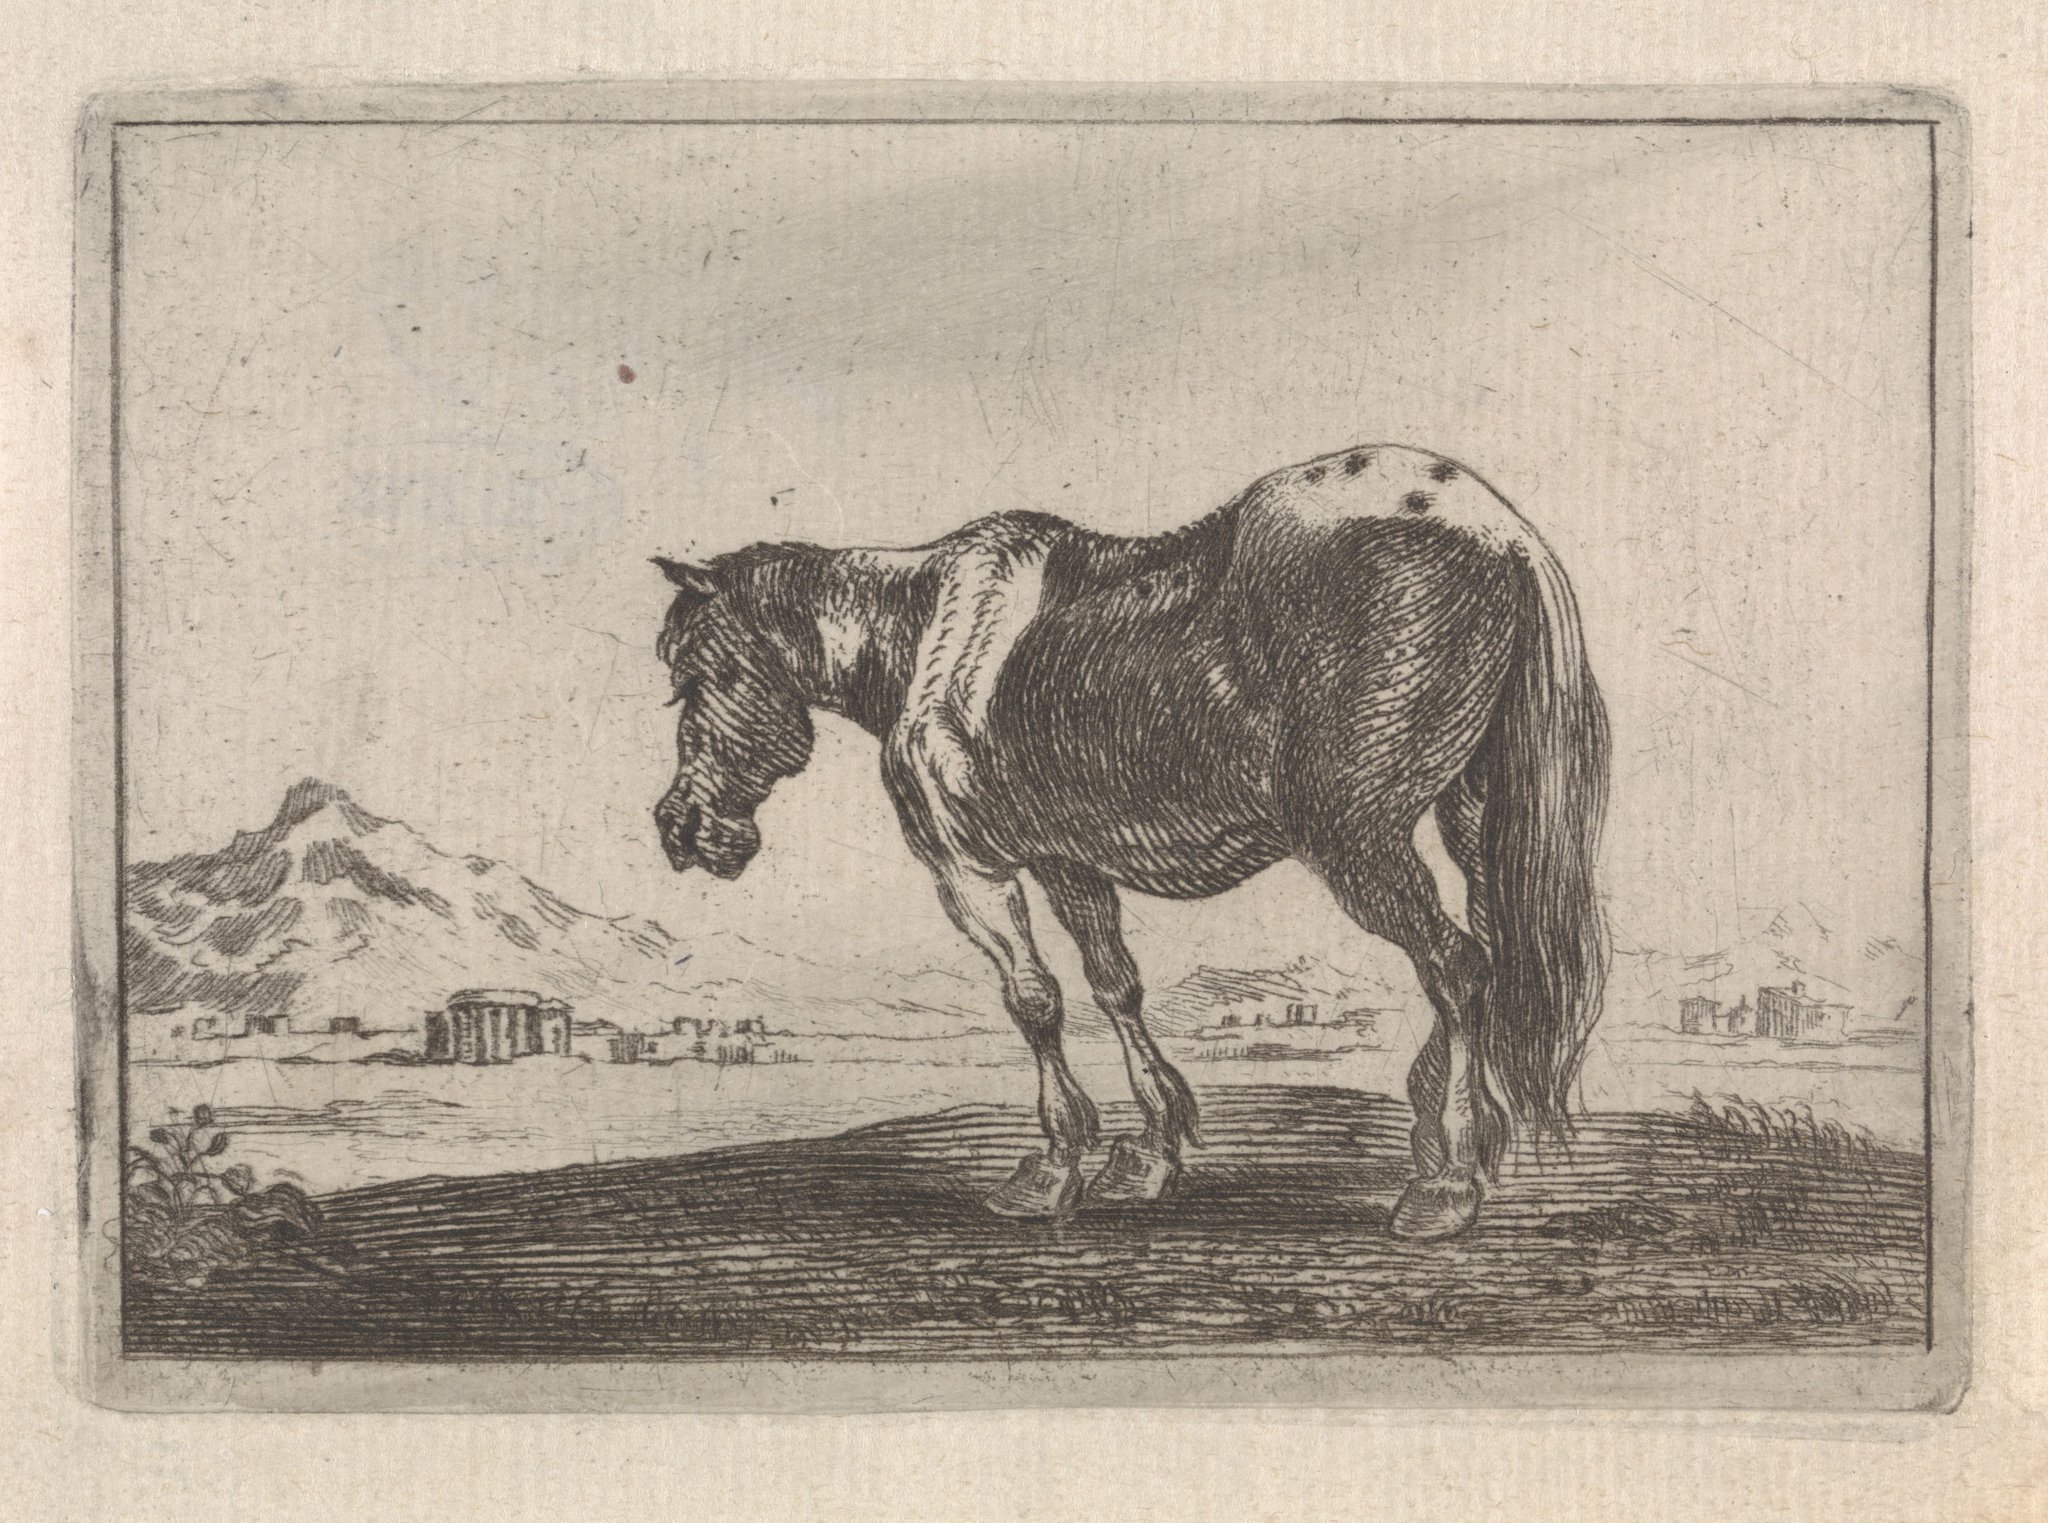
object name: print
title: Paard staande in een landschap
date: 1654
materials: paper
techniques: etching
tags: landscapes, horse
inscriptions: collector's mark: Lugt 2228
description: In een landschap staat een paard met vier zwarte stippen op zijn kont. Op de achtergrond is een heuvel te zien. Deze prent maakt deel uit van een tiendelige serie over diverse dieren.